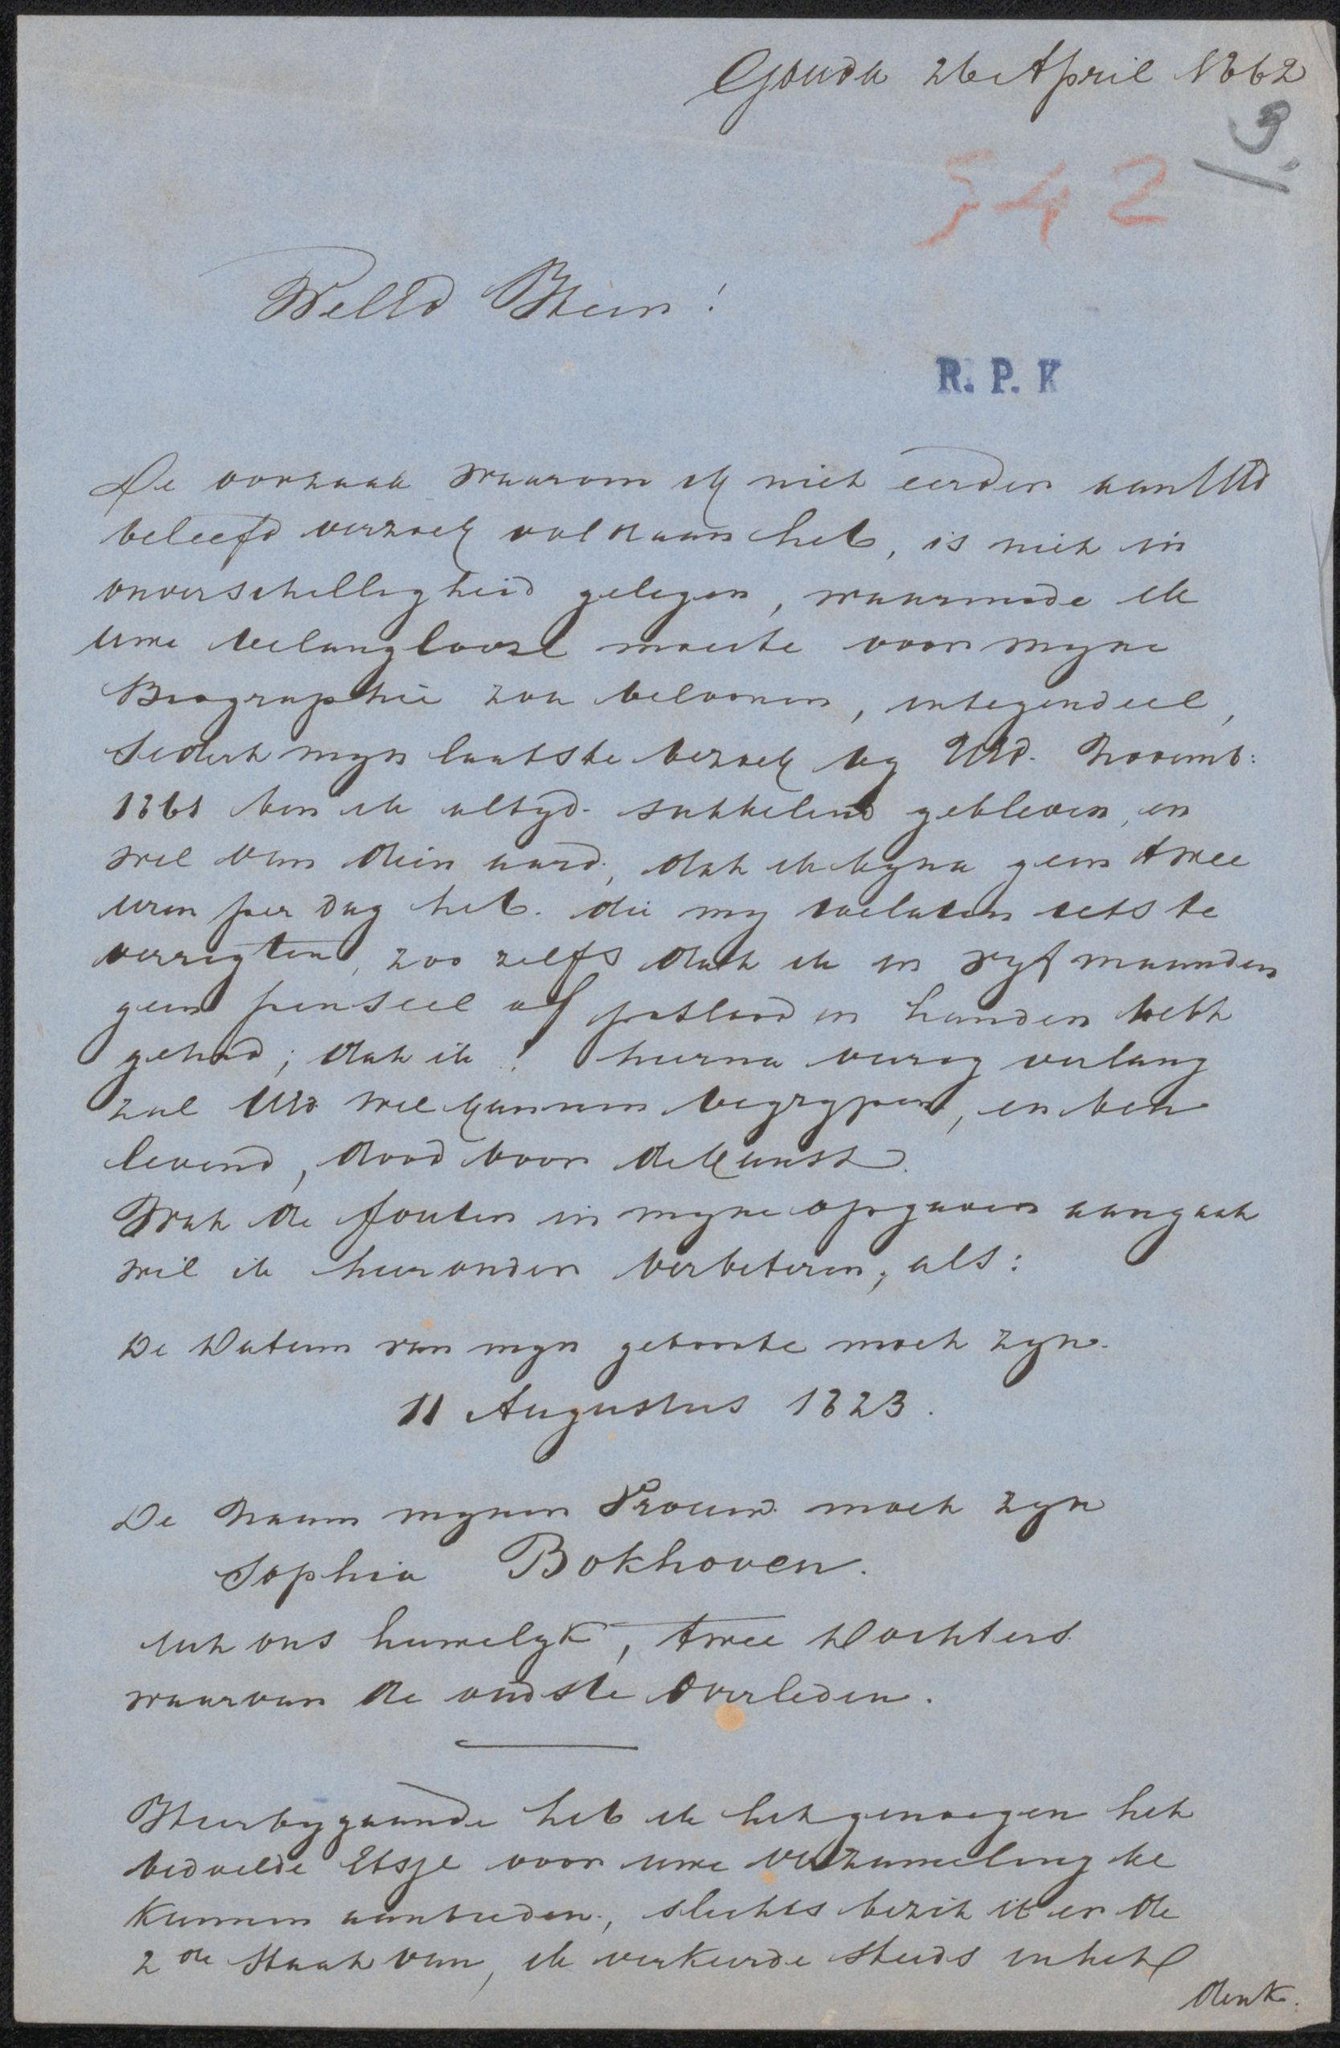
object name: letter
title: Brief aan Christiaan Kramm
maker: gijsbertus johannes verspuy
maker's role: print maker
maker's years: 1823-1862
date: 1862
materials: ink, paper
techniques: pen, writing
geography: gouda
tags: christiaan kramm, the graphic arts, family life, diseases, art collecting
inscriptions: collector's mark: Lugt 2233